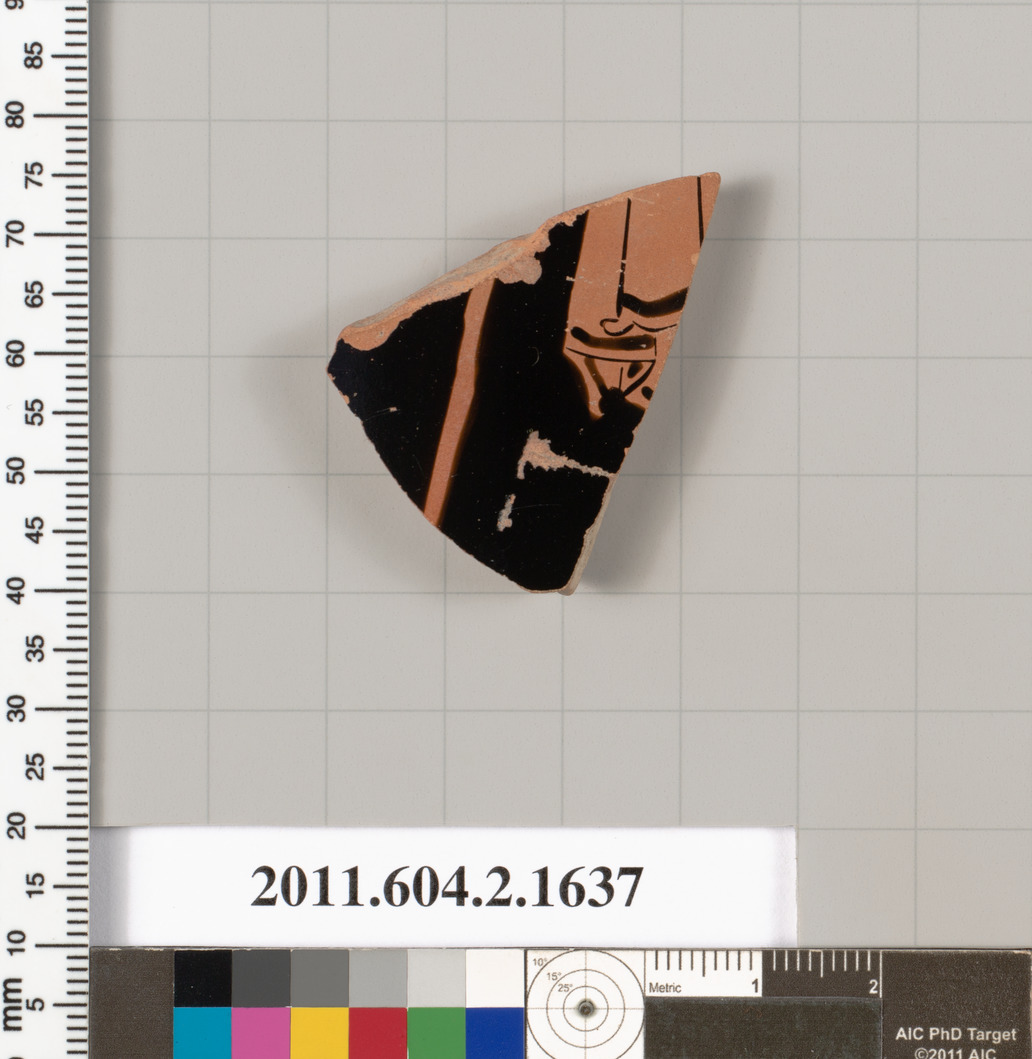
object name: skyphos fragment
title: Terracotta fragment of a skyphos (deep drinking cup)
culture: greek, attic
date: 475-451 BCE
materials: terracotta